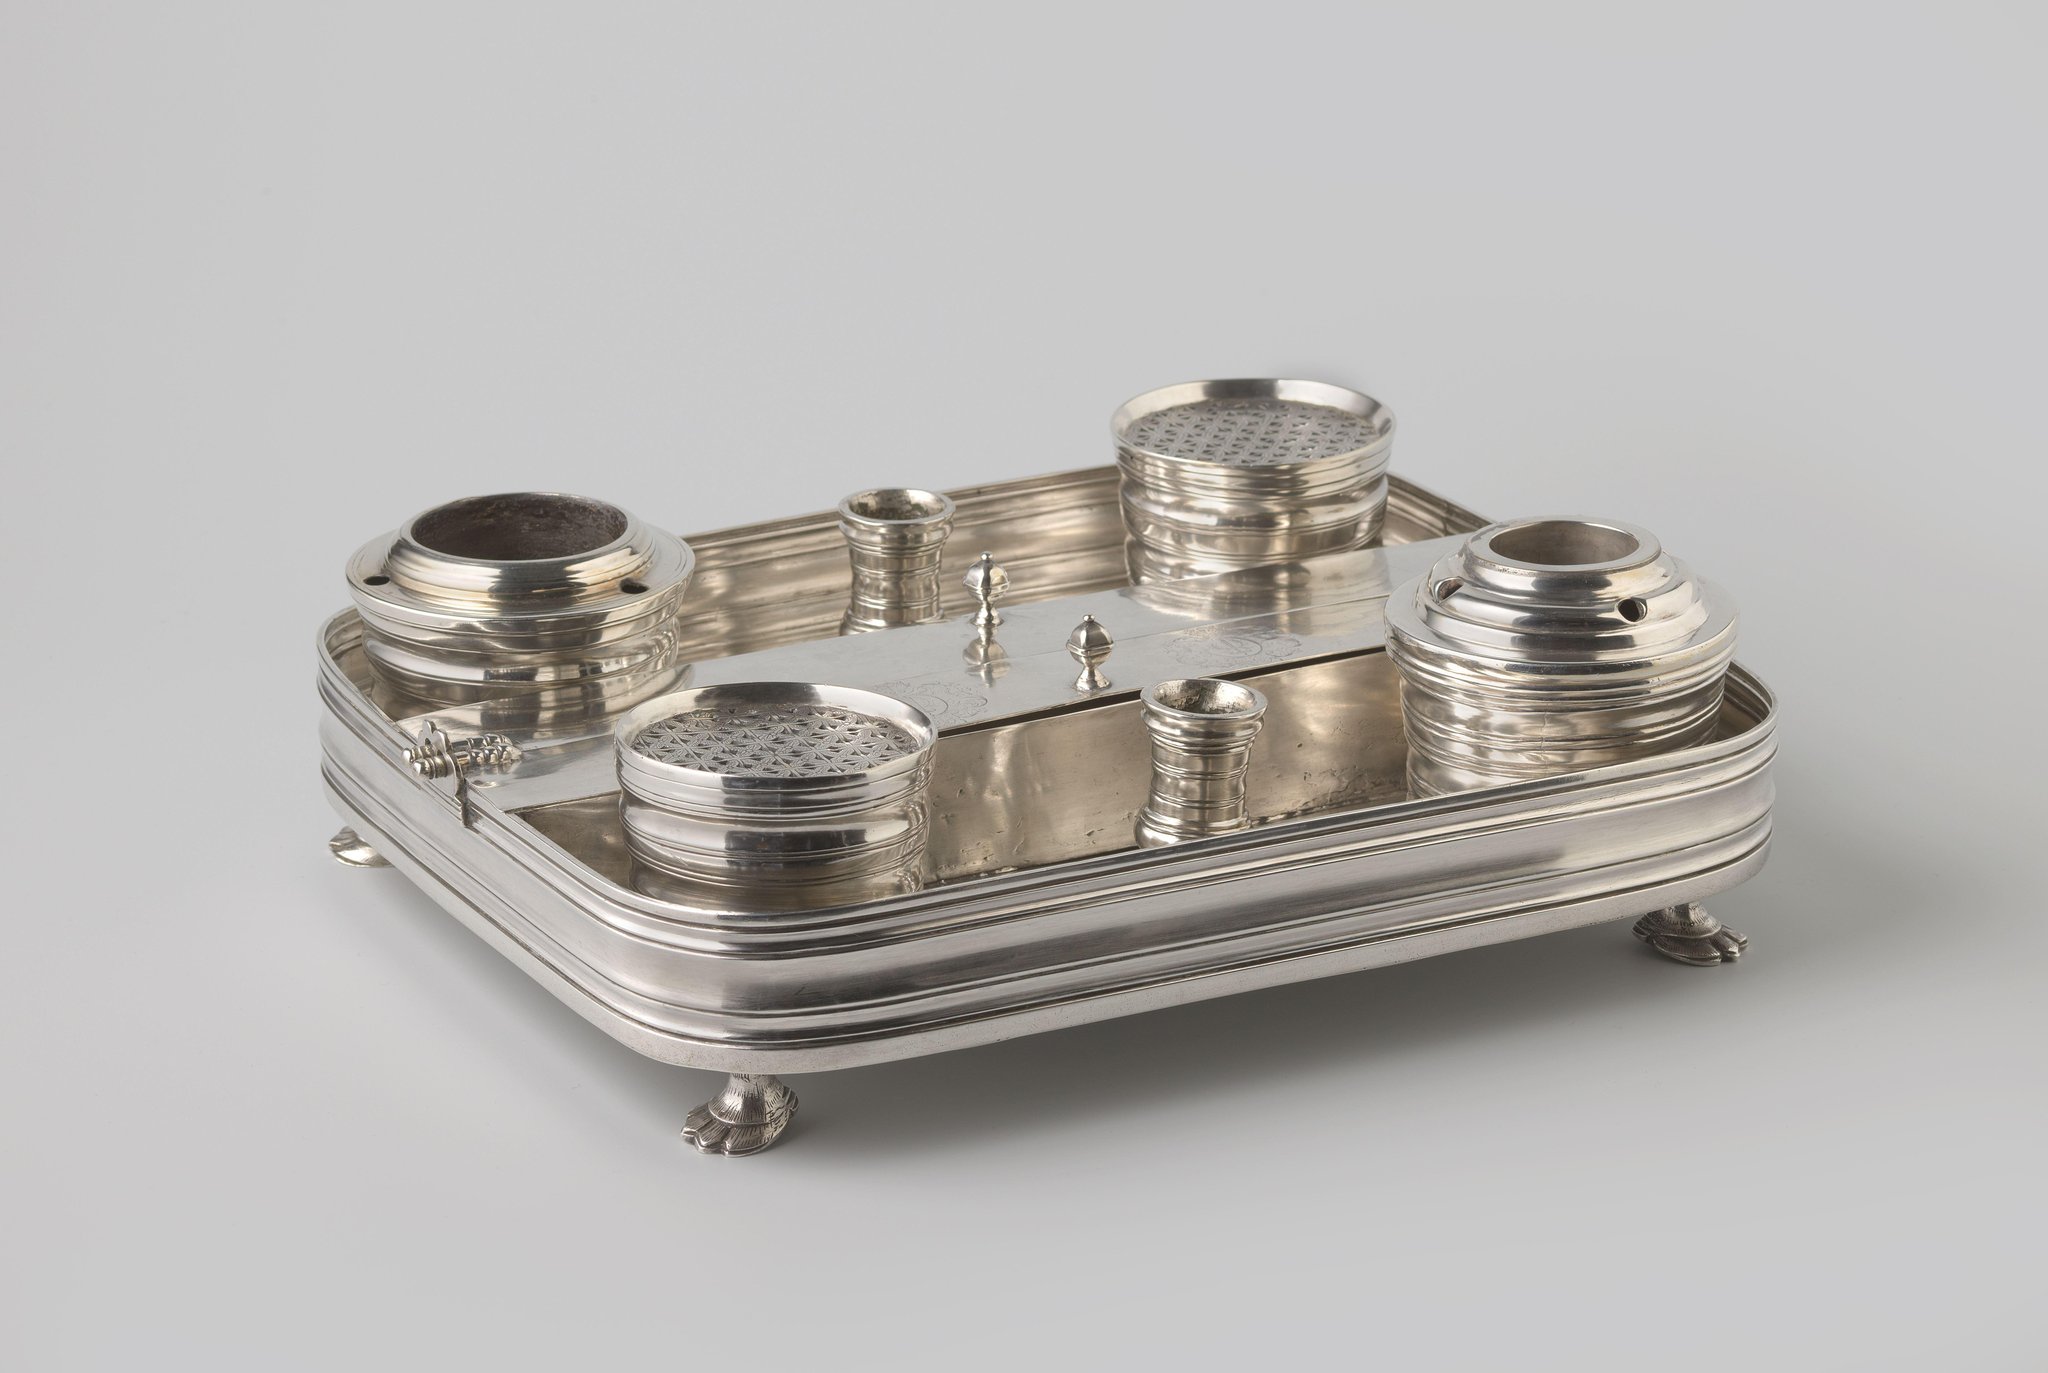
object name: inkstand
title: Inktstel met wapen Batavia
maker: jurriaan van kalker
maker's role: goldsmith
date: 1725-1750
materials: silver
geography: jogjakarta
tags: device (as symbol of the state, etc.) (+ city; municipal), batavia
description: Silver inkstand, possibly by Jurriaan van Kalker in Batavia, 1730 or 1731. The inkstand, with the arms of Batavia, was probably in use at a government department in the Dutch East Indies. It contains two pots for ink and two for fine sand. After writing, the sand was sprinkled over the page to help dry the ink.